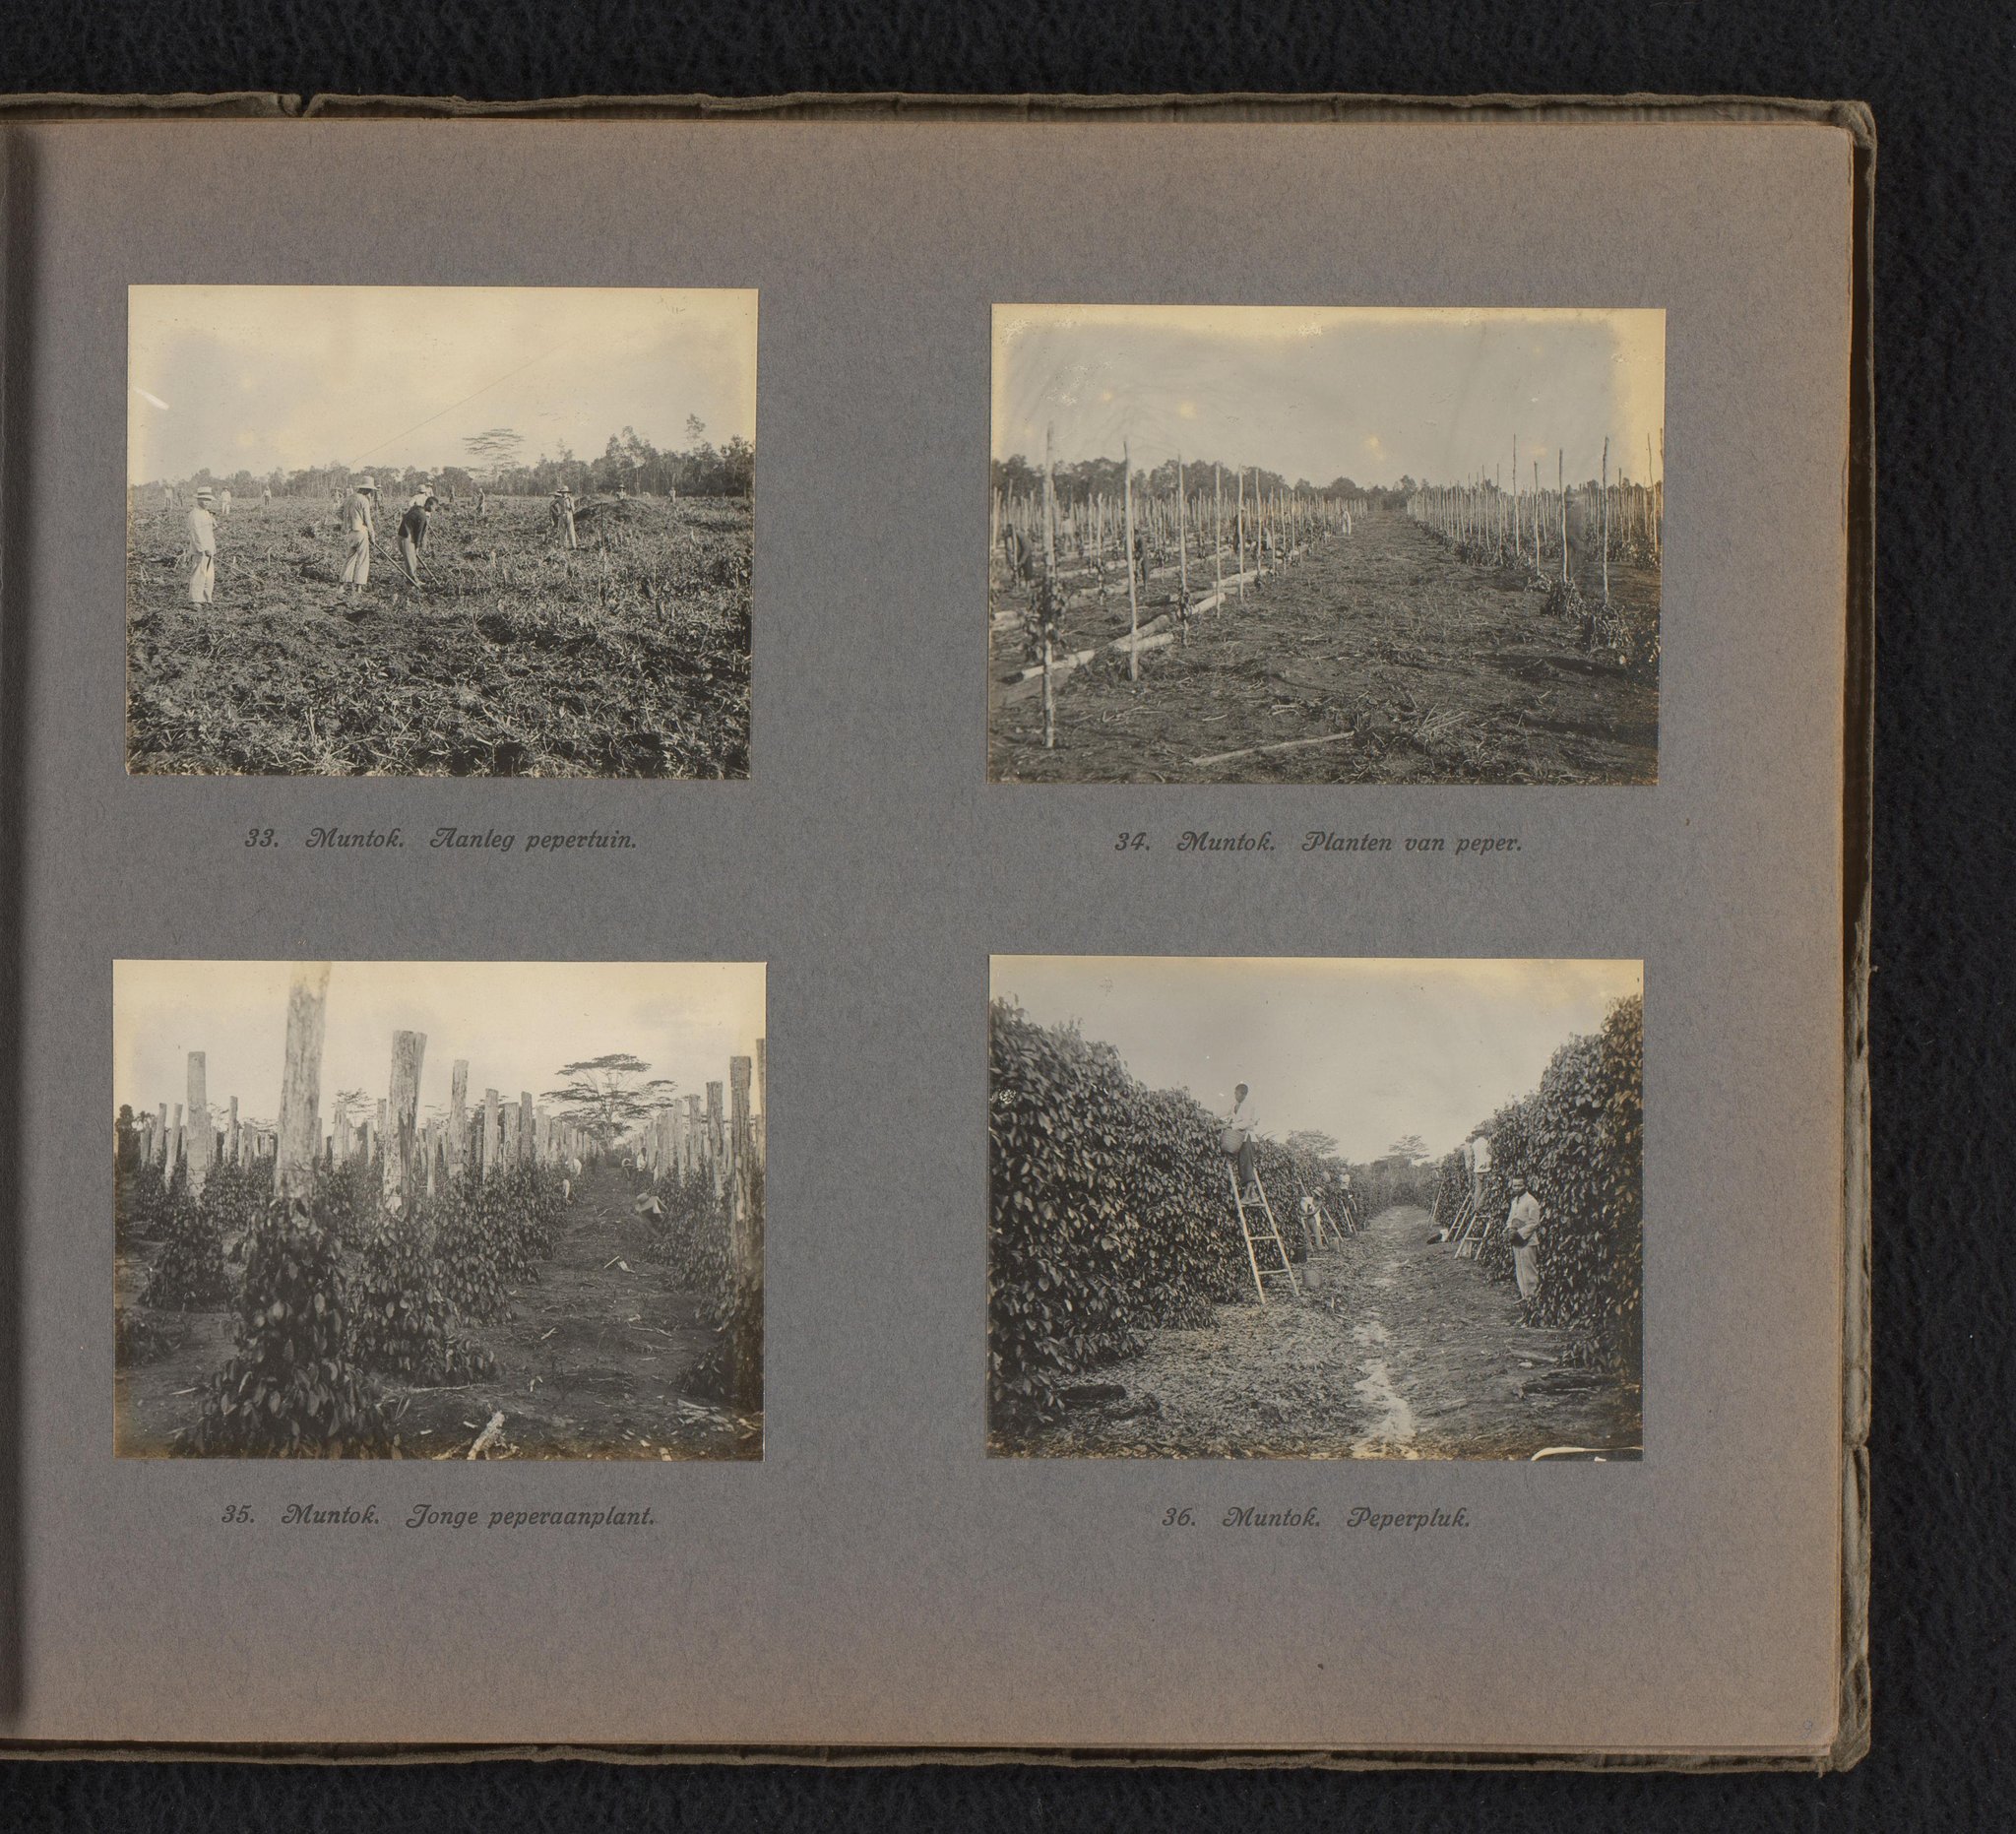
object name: album leaf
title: Peperplanten te Muntok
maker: Anonymous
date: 1907-1919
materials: cardboard, photographic support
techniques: gelatin silver print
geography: bangka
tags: robert julius boers, colonial system, plantation, pepper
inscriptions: inscription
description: Albumblad met vier foto's genummerd 33-36 van de pepercultuur te Muntok op Banka: ontginning, aanplant en oogst. Onderdeel van het Banka-Album met foto's over het eiland Banka en de tinwinning door het staatsbedrijf de Banka-tinwinning in de periode ca. 1907-1919.